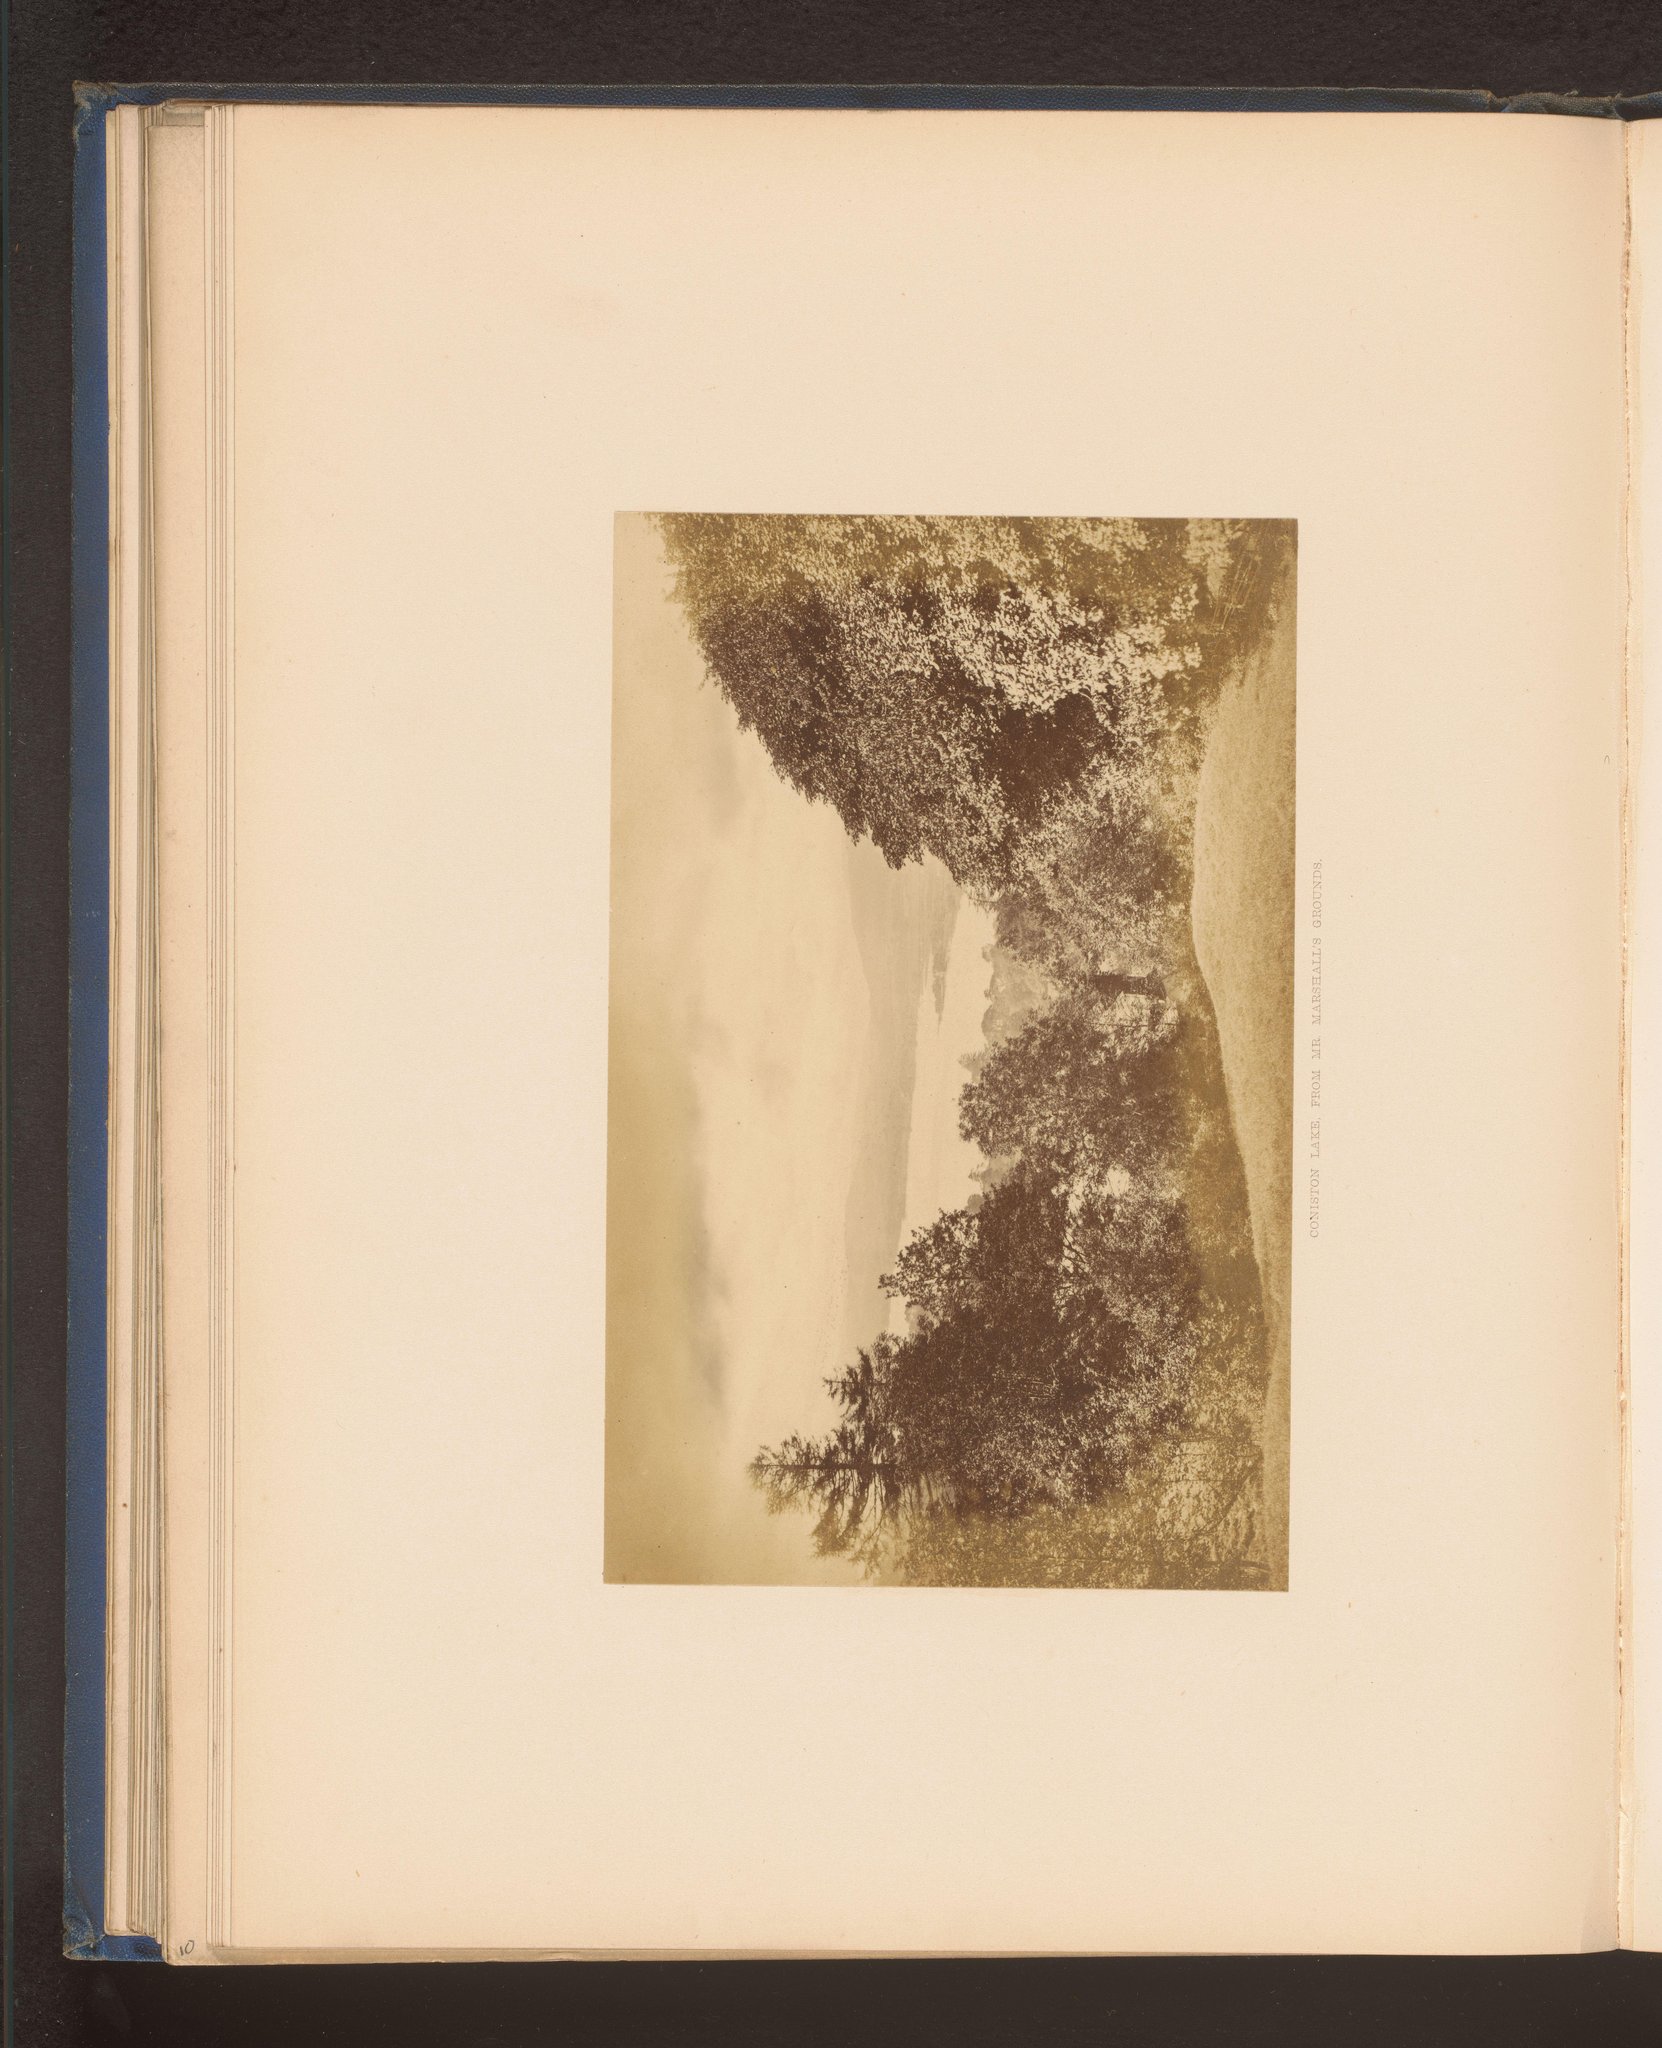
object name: photograph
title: Gezicht op Coniston Water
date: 1857-1867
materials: photographic support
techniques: albumen print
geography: lake district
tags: lake